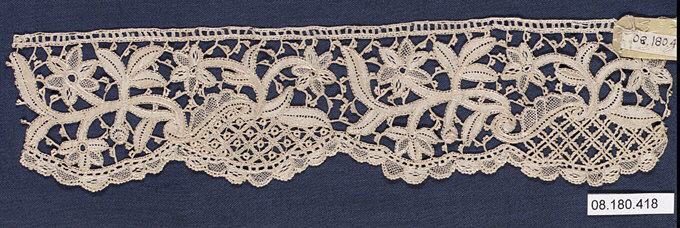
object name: fragment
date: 1801-1900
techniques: lace